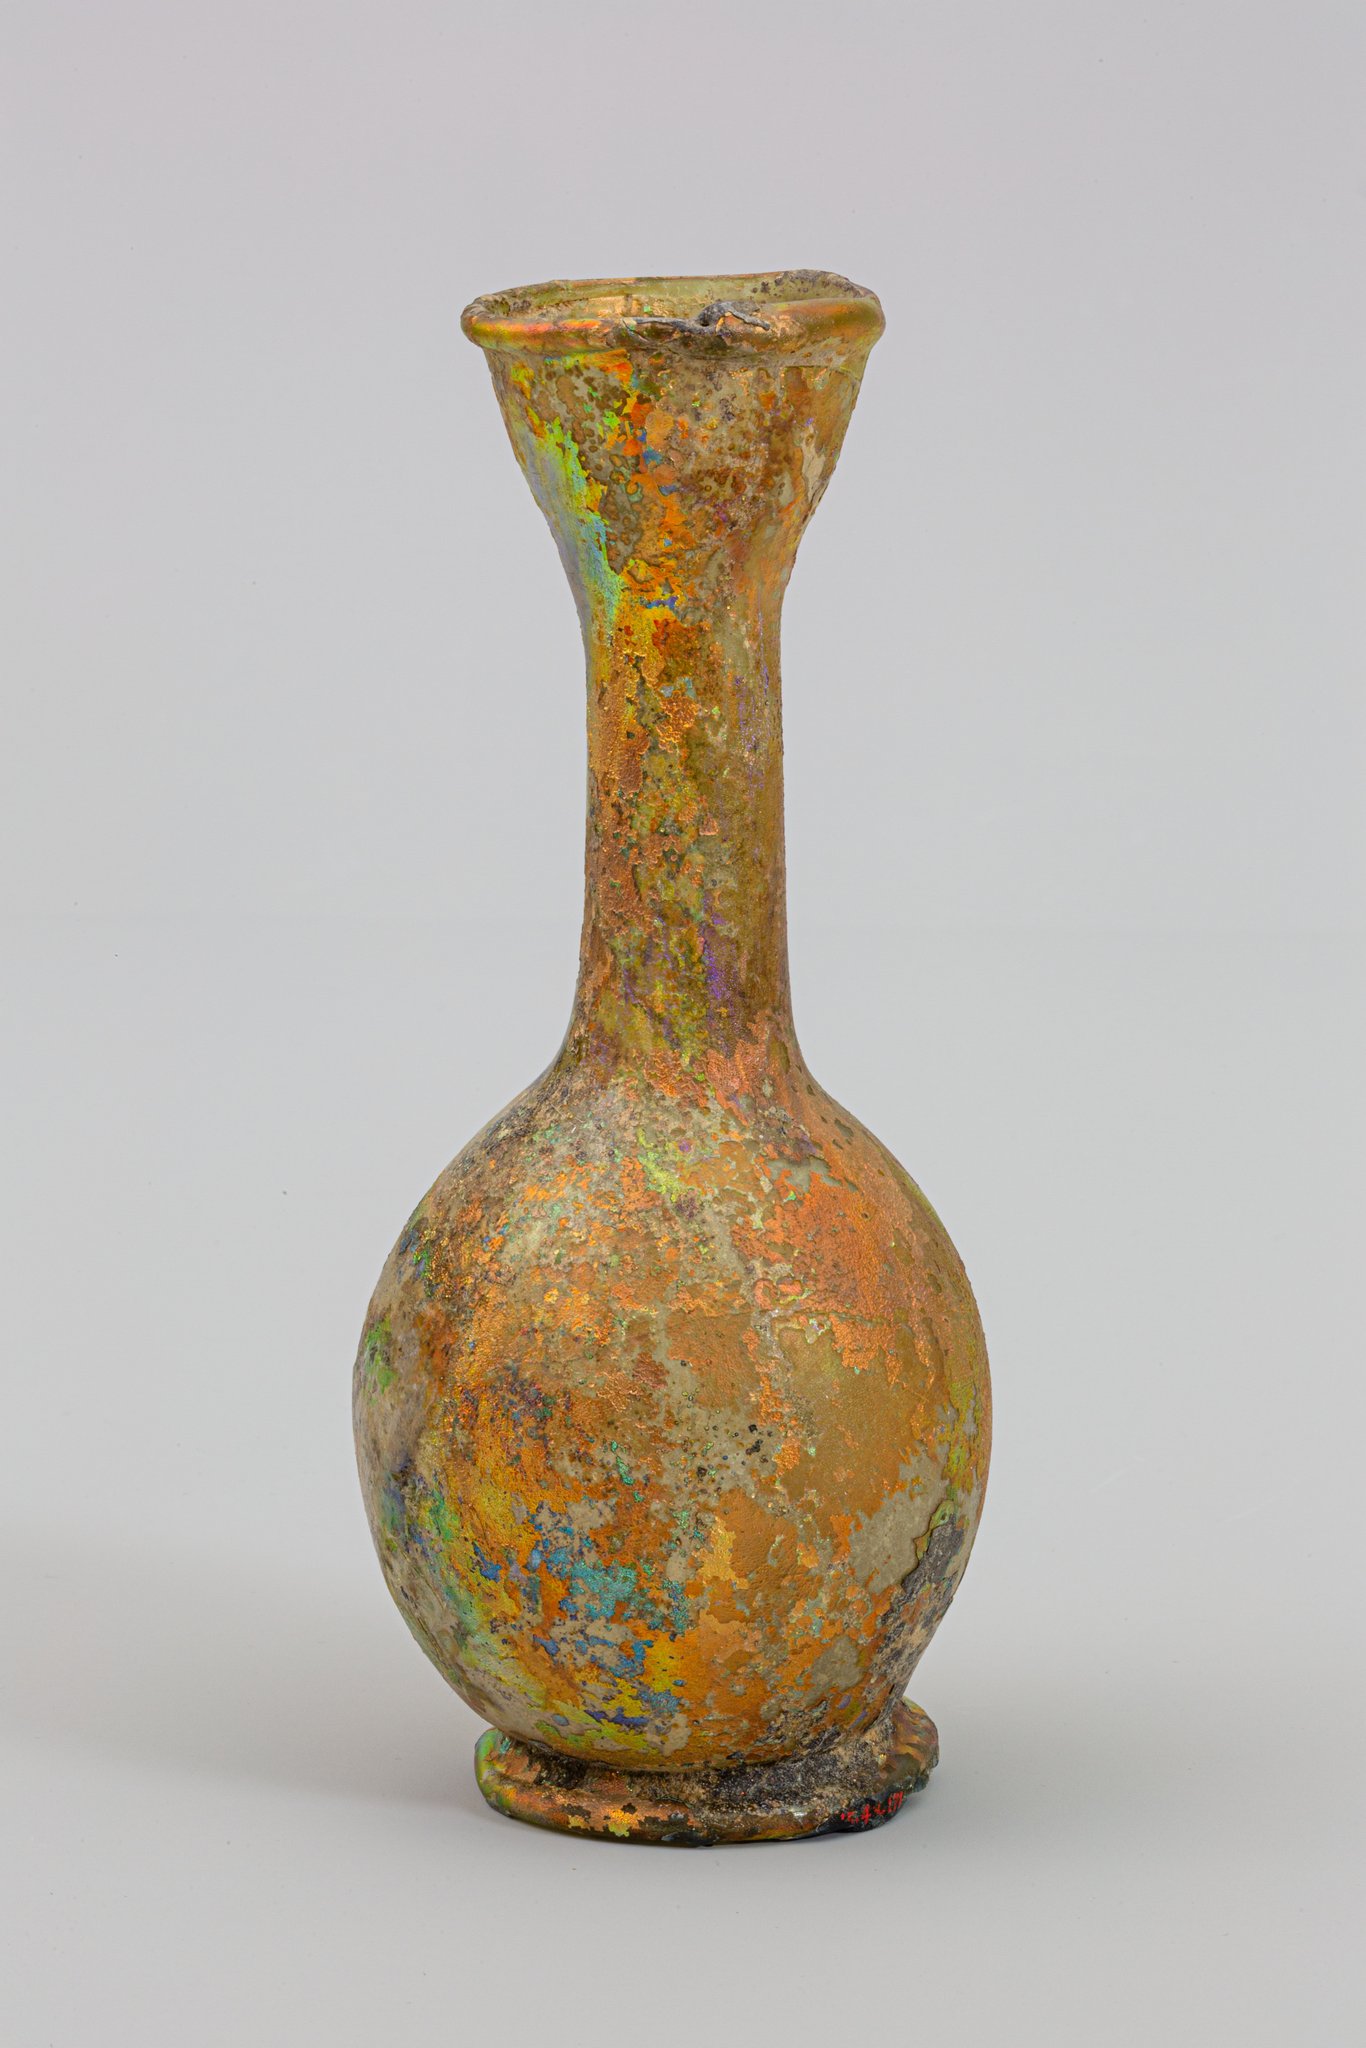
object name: flask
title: Glass flask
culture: roman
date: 301-400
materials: glass